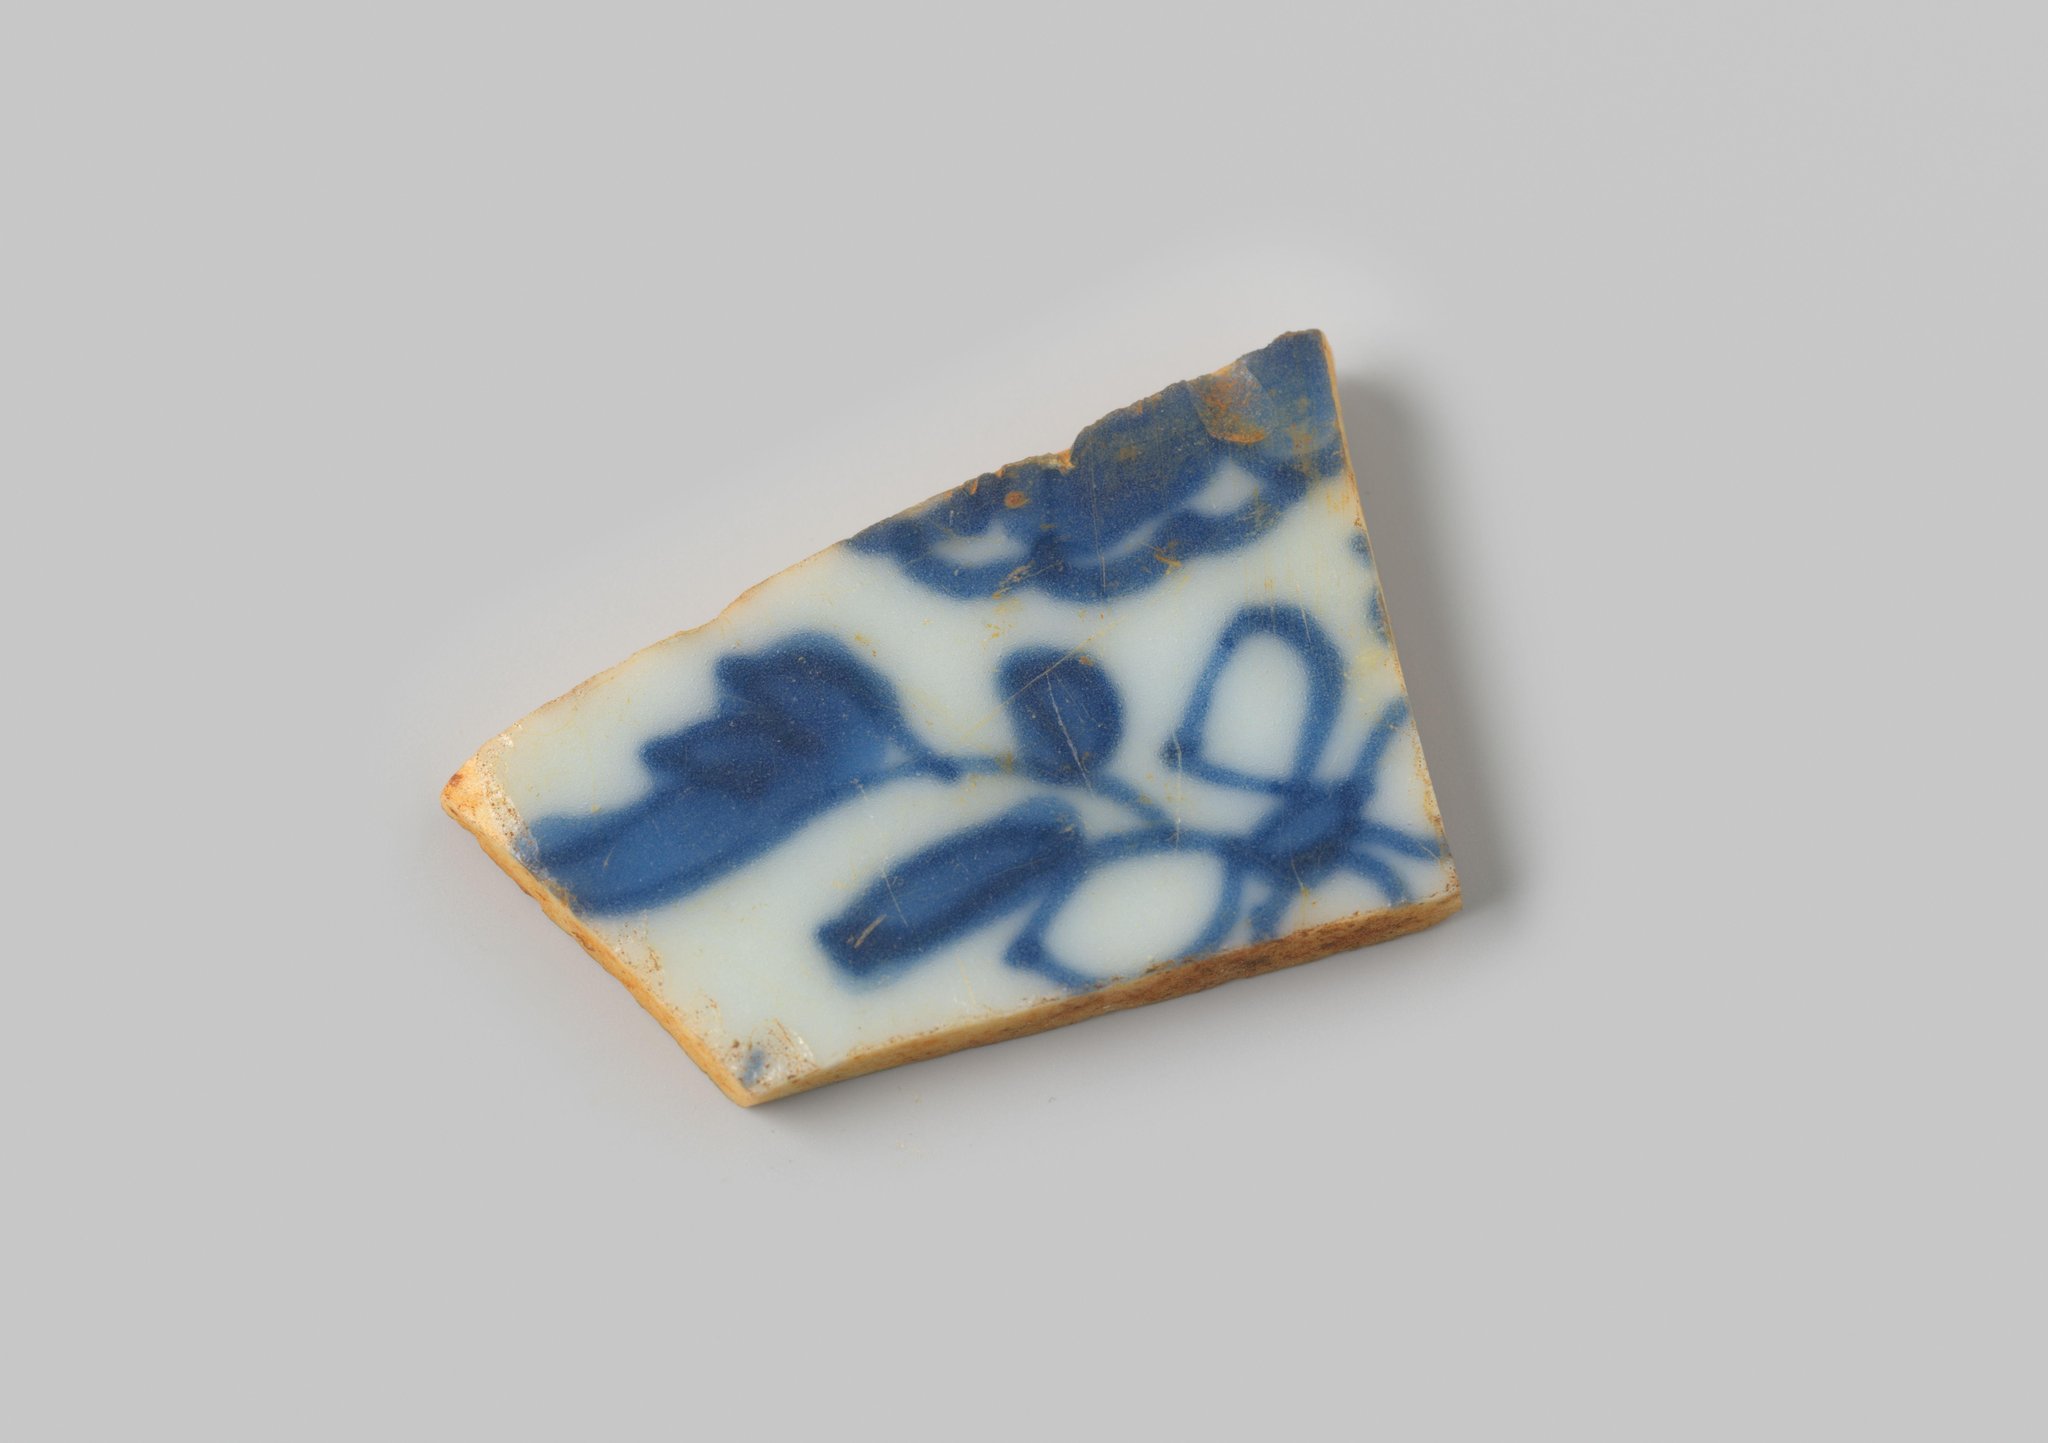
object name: sherd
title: Scherf van een schotel uit het wrak van de Oost-Indiëvaarder Hollandia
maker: Anonymous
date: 1700-1743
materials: porcelain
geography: netherlands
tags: verenigde oostindische compagnie, hollandia (schip), annet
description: Porcelain, saucer, type 4; fragm of base, sim. NG 1980-27H3206i.